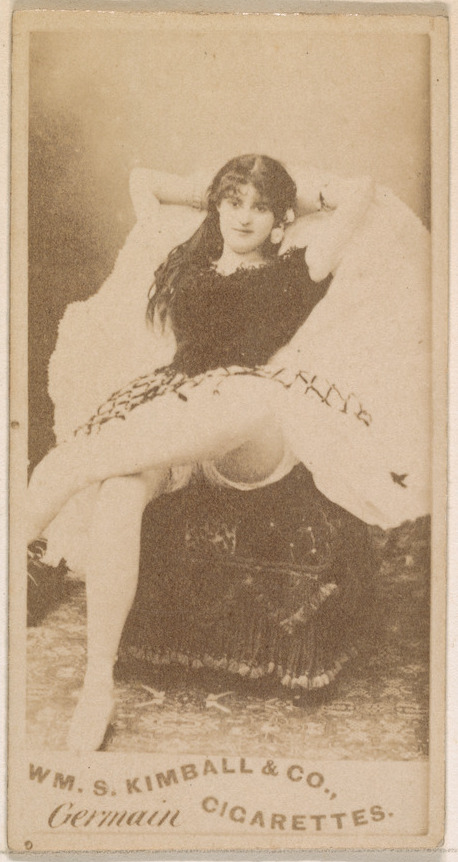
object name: photograph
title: Miss Germain, from the Actresses series (N203) issued by Wm. S. Kimball & Co.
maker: william s. kimball & company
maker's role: publisher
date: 1889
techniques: color lithograph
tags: portraits,women,actresses